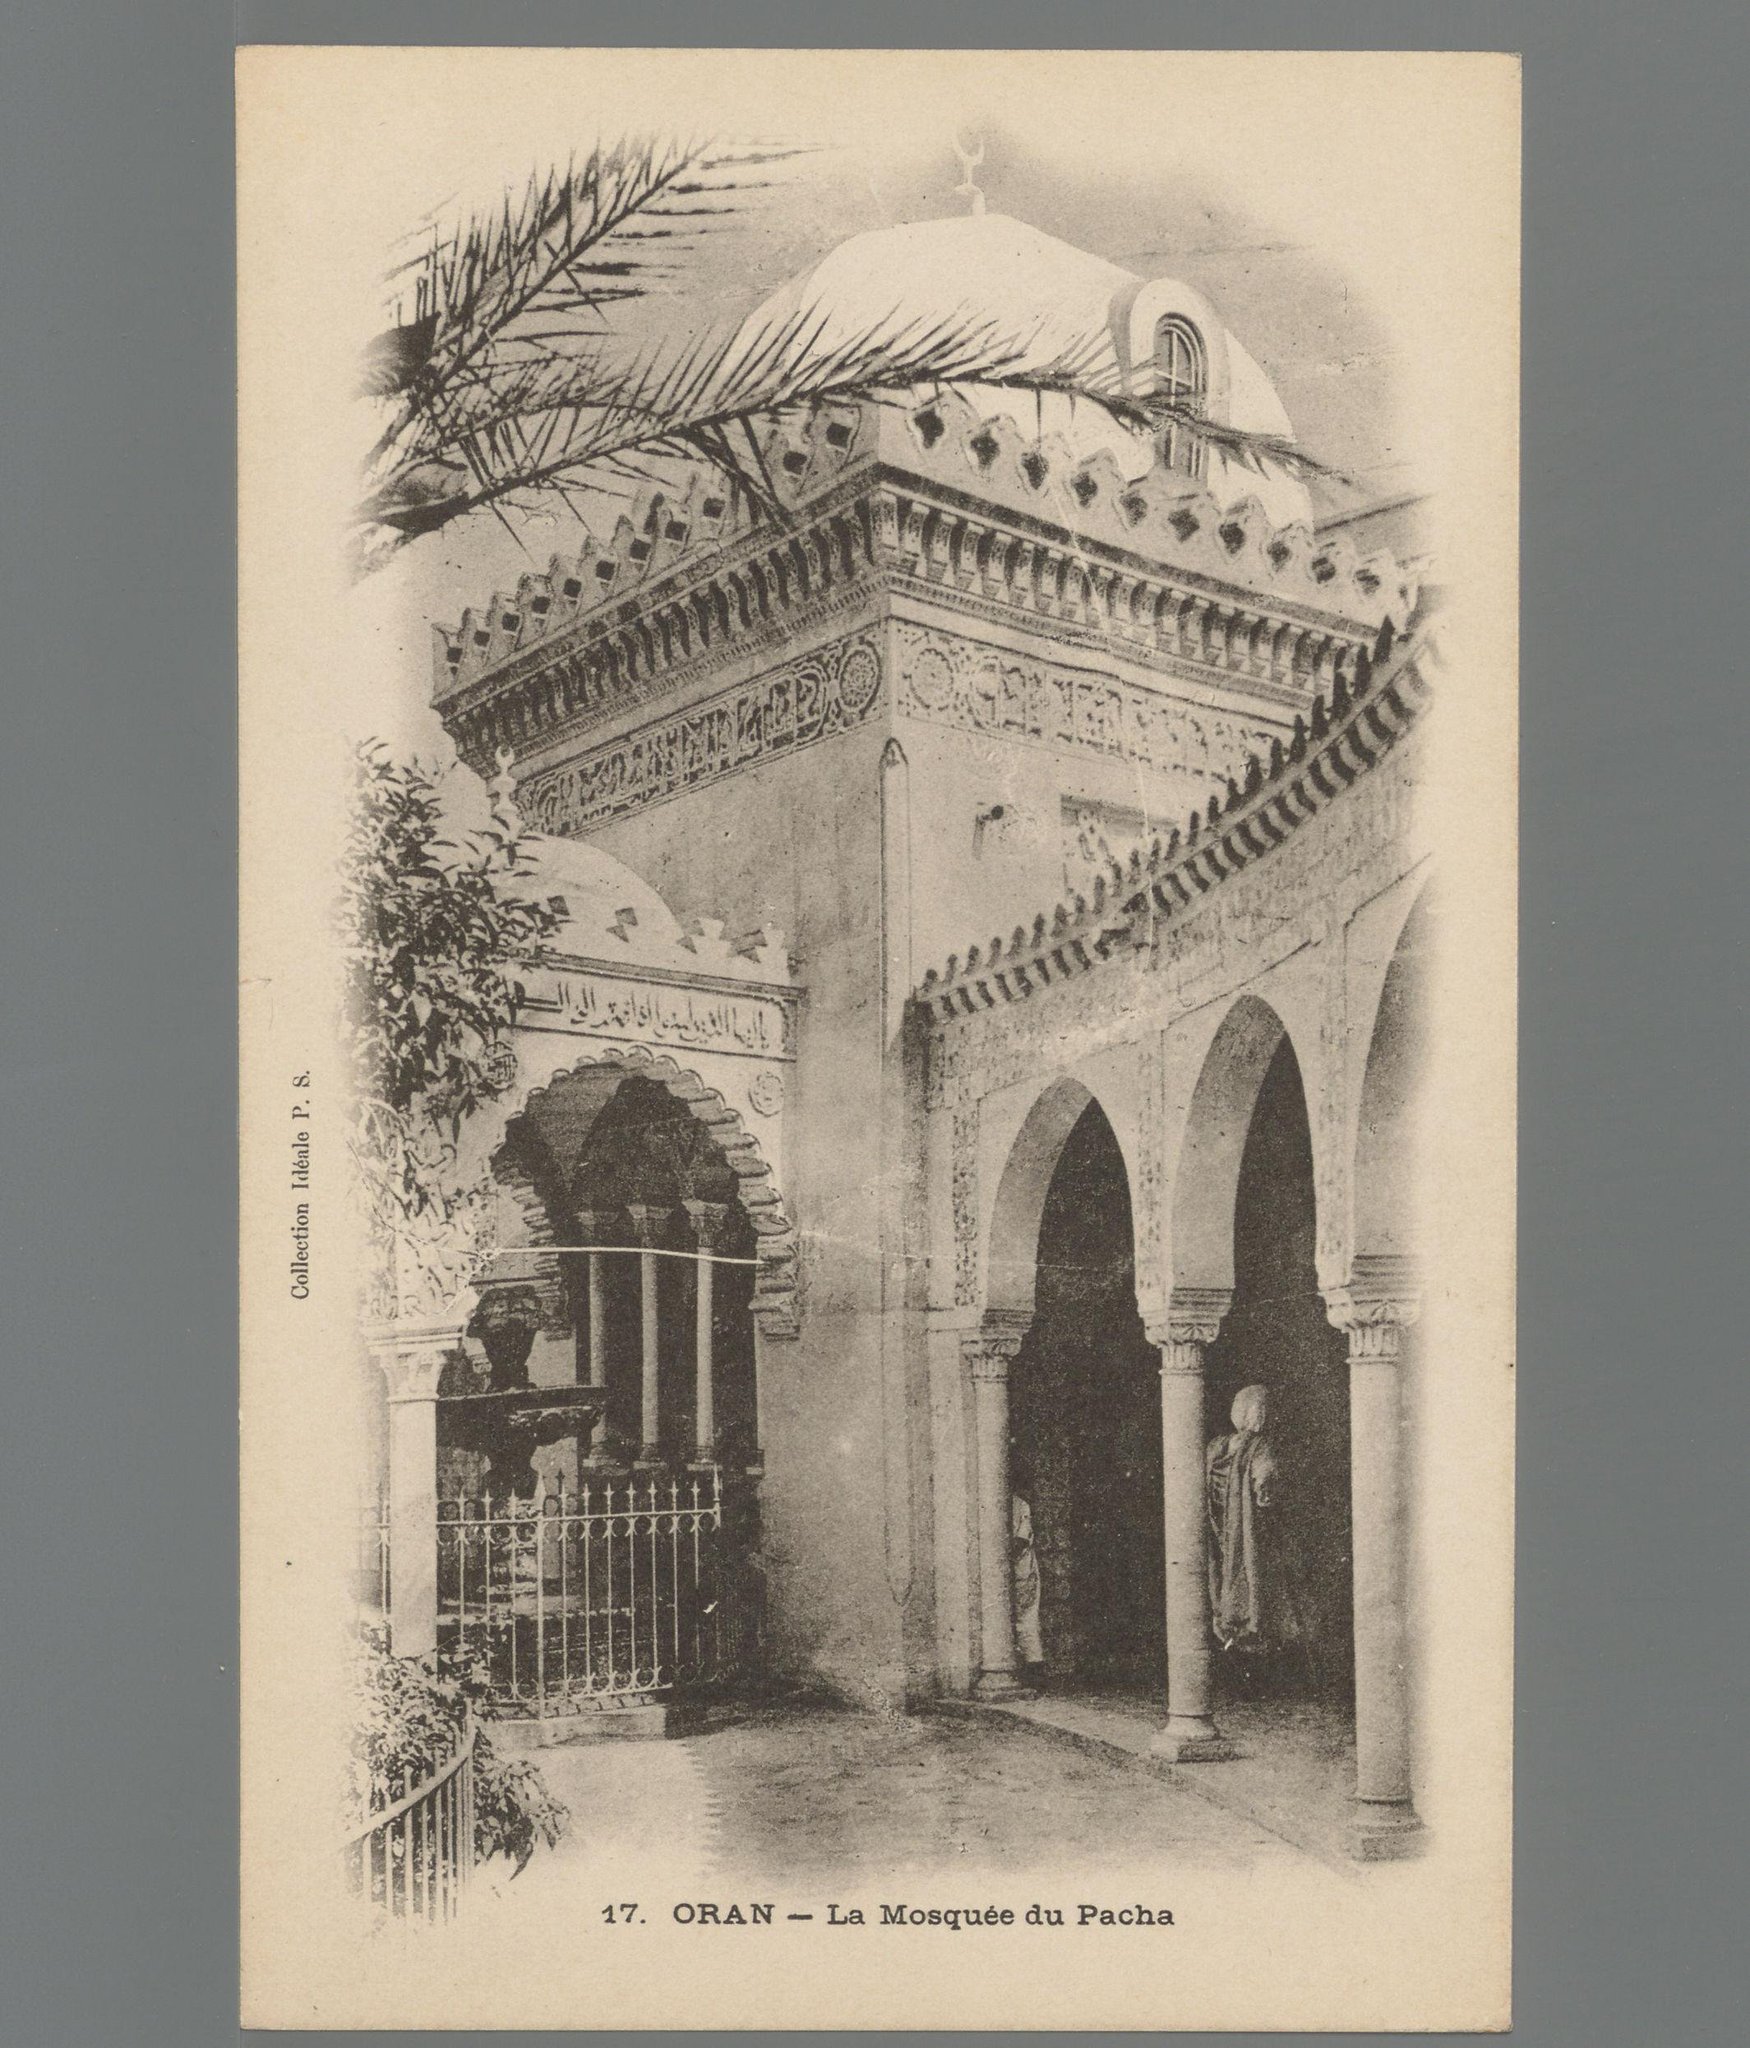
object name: photomechanical print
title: Oran. La Mosquée du Pacha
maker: paul satragno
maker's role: printer, publisher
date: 1903-1905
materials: cardboard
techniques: photograph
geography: algiers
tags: temple, shrine ~ islam, mohammedanism